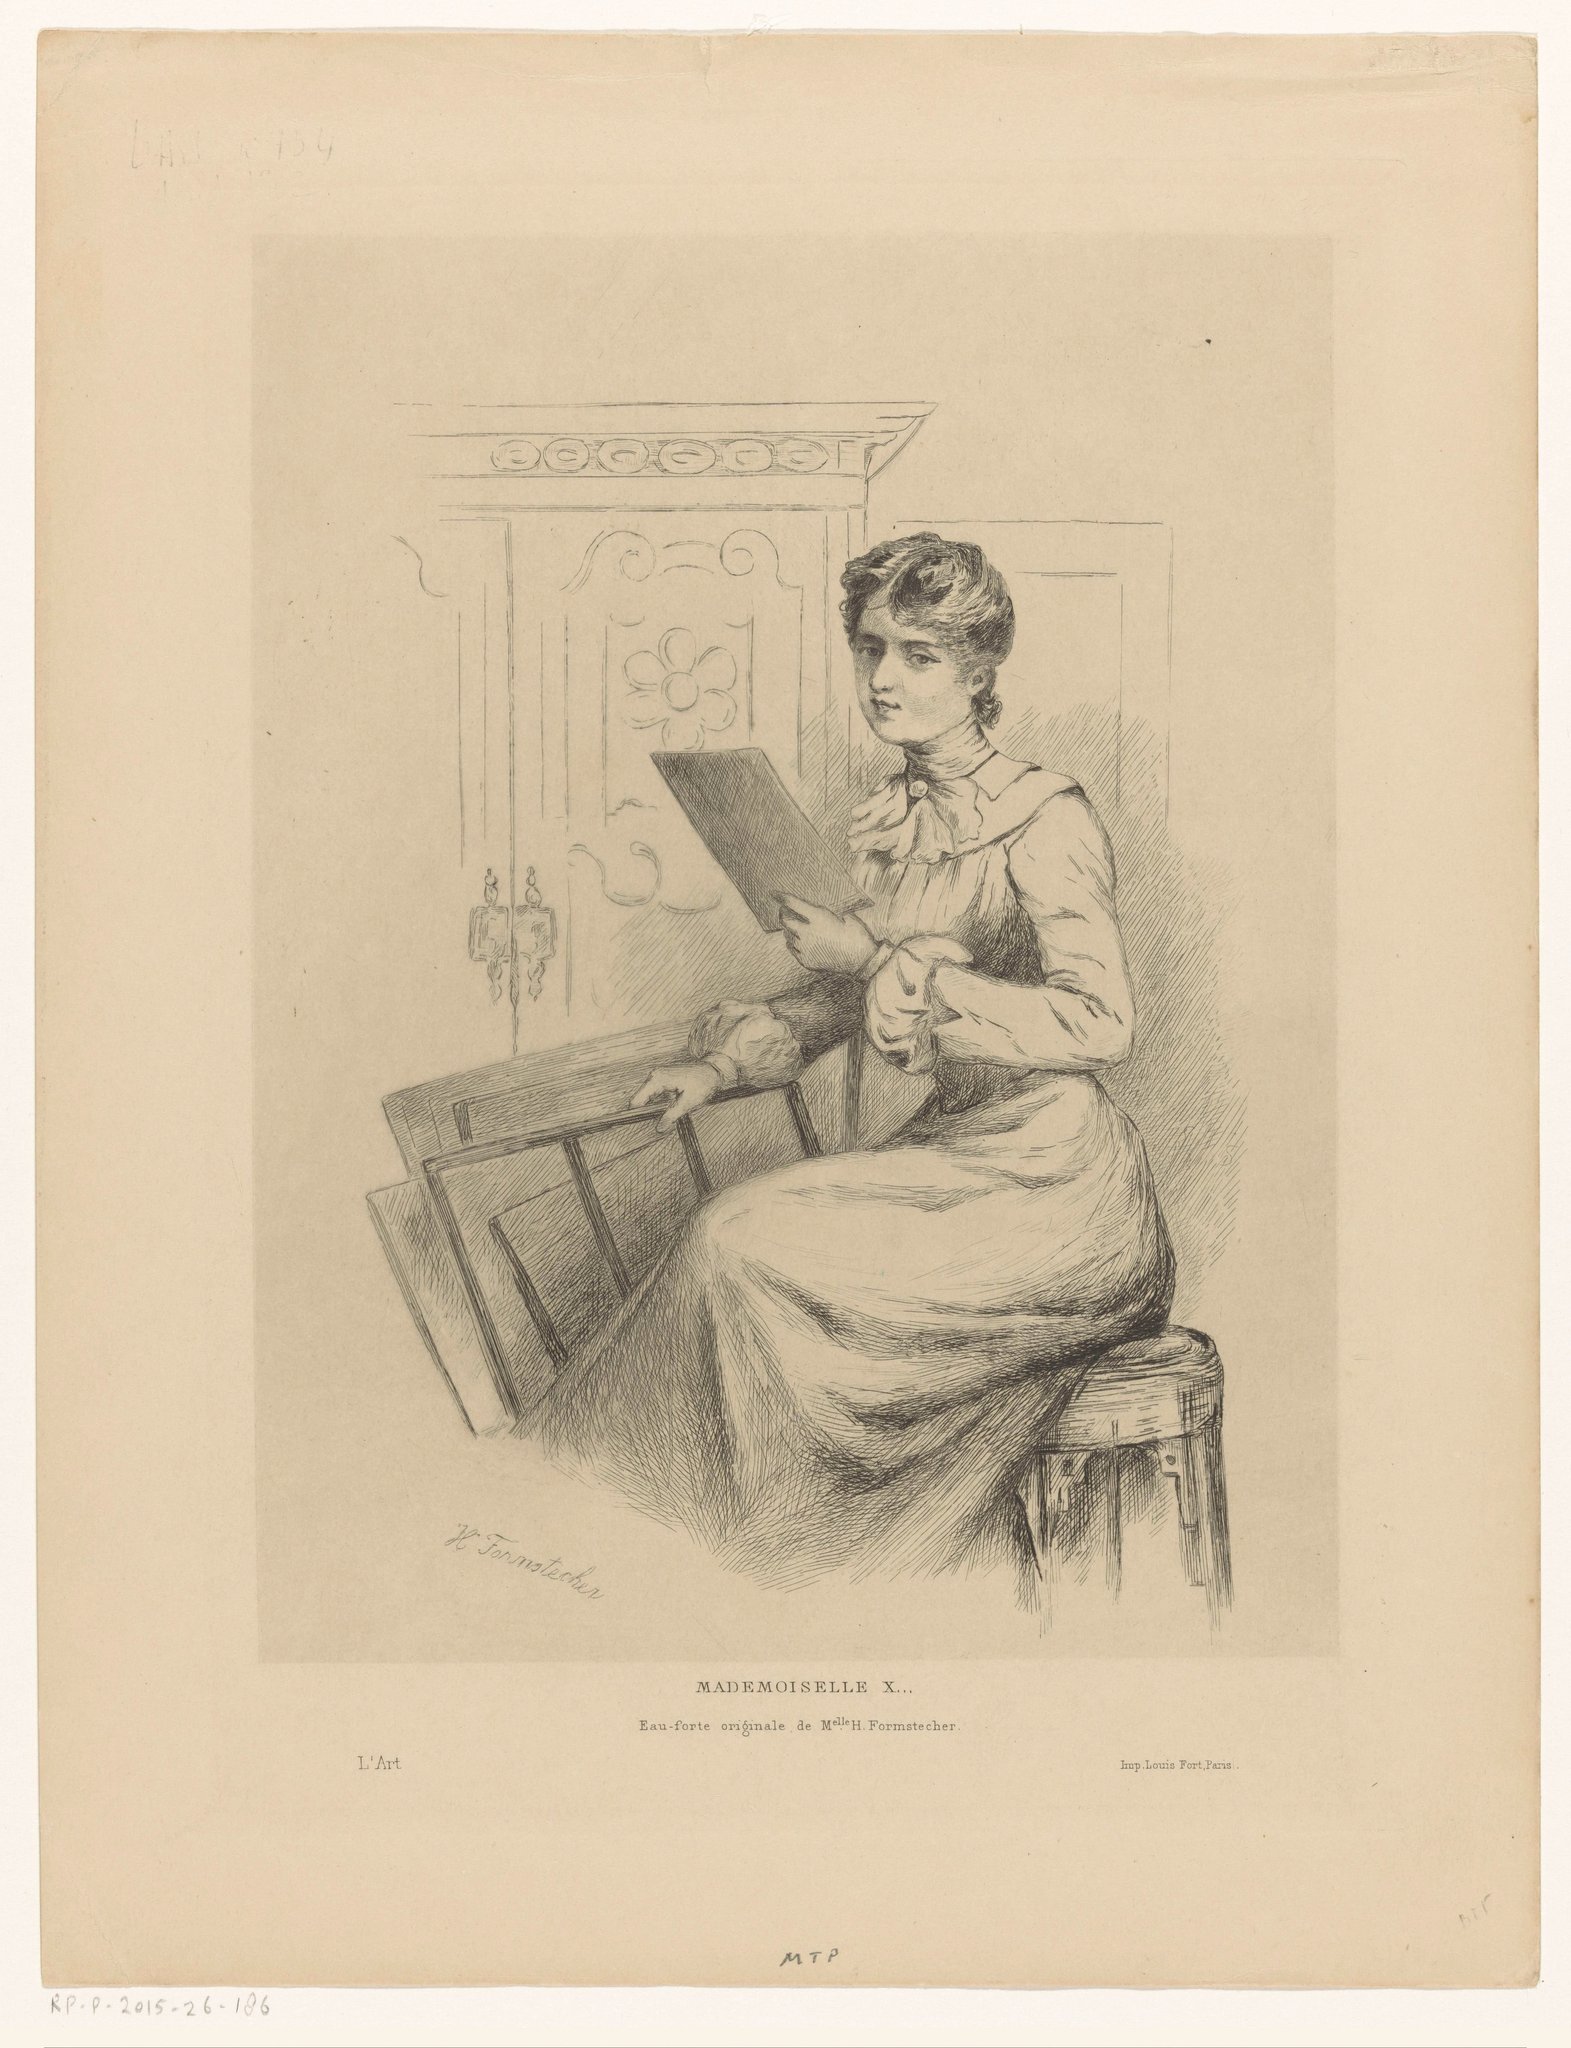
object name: print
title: Mademoiselle X (...)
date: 1862-1930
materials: paper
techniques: etching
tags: print, e.g.: engraving, etching, lithograph, anonymous historical person portrayed alone, art collecting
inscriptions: collector's mark: Lugt 2228, collector's mark: Lugt 4779